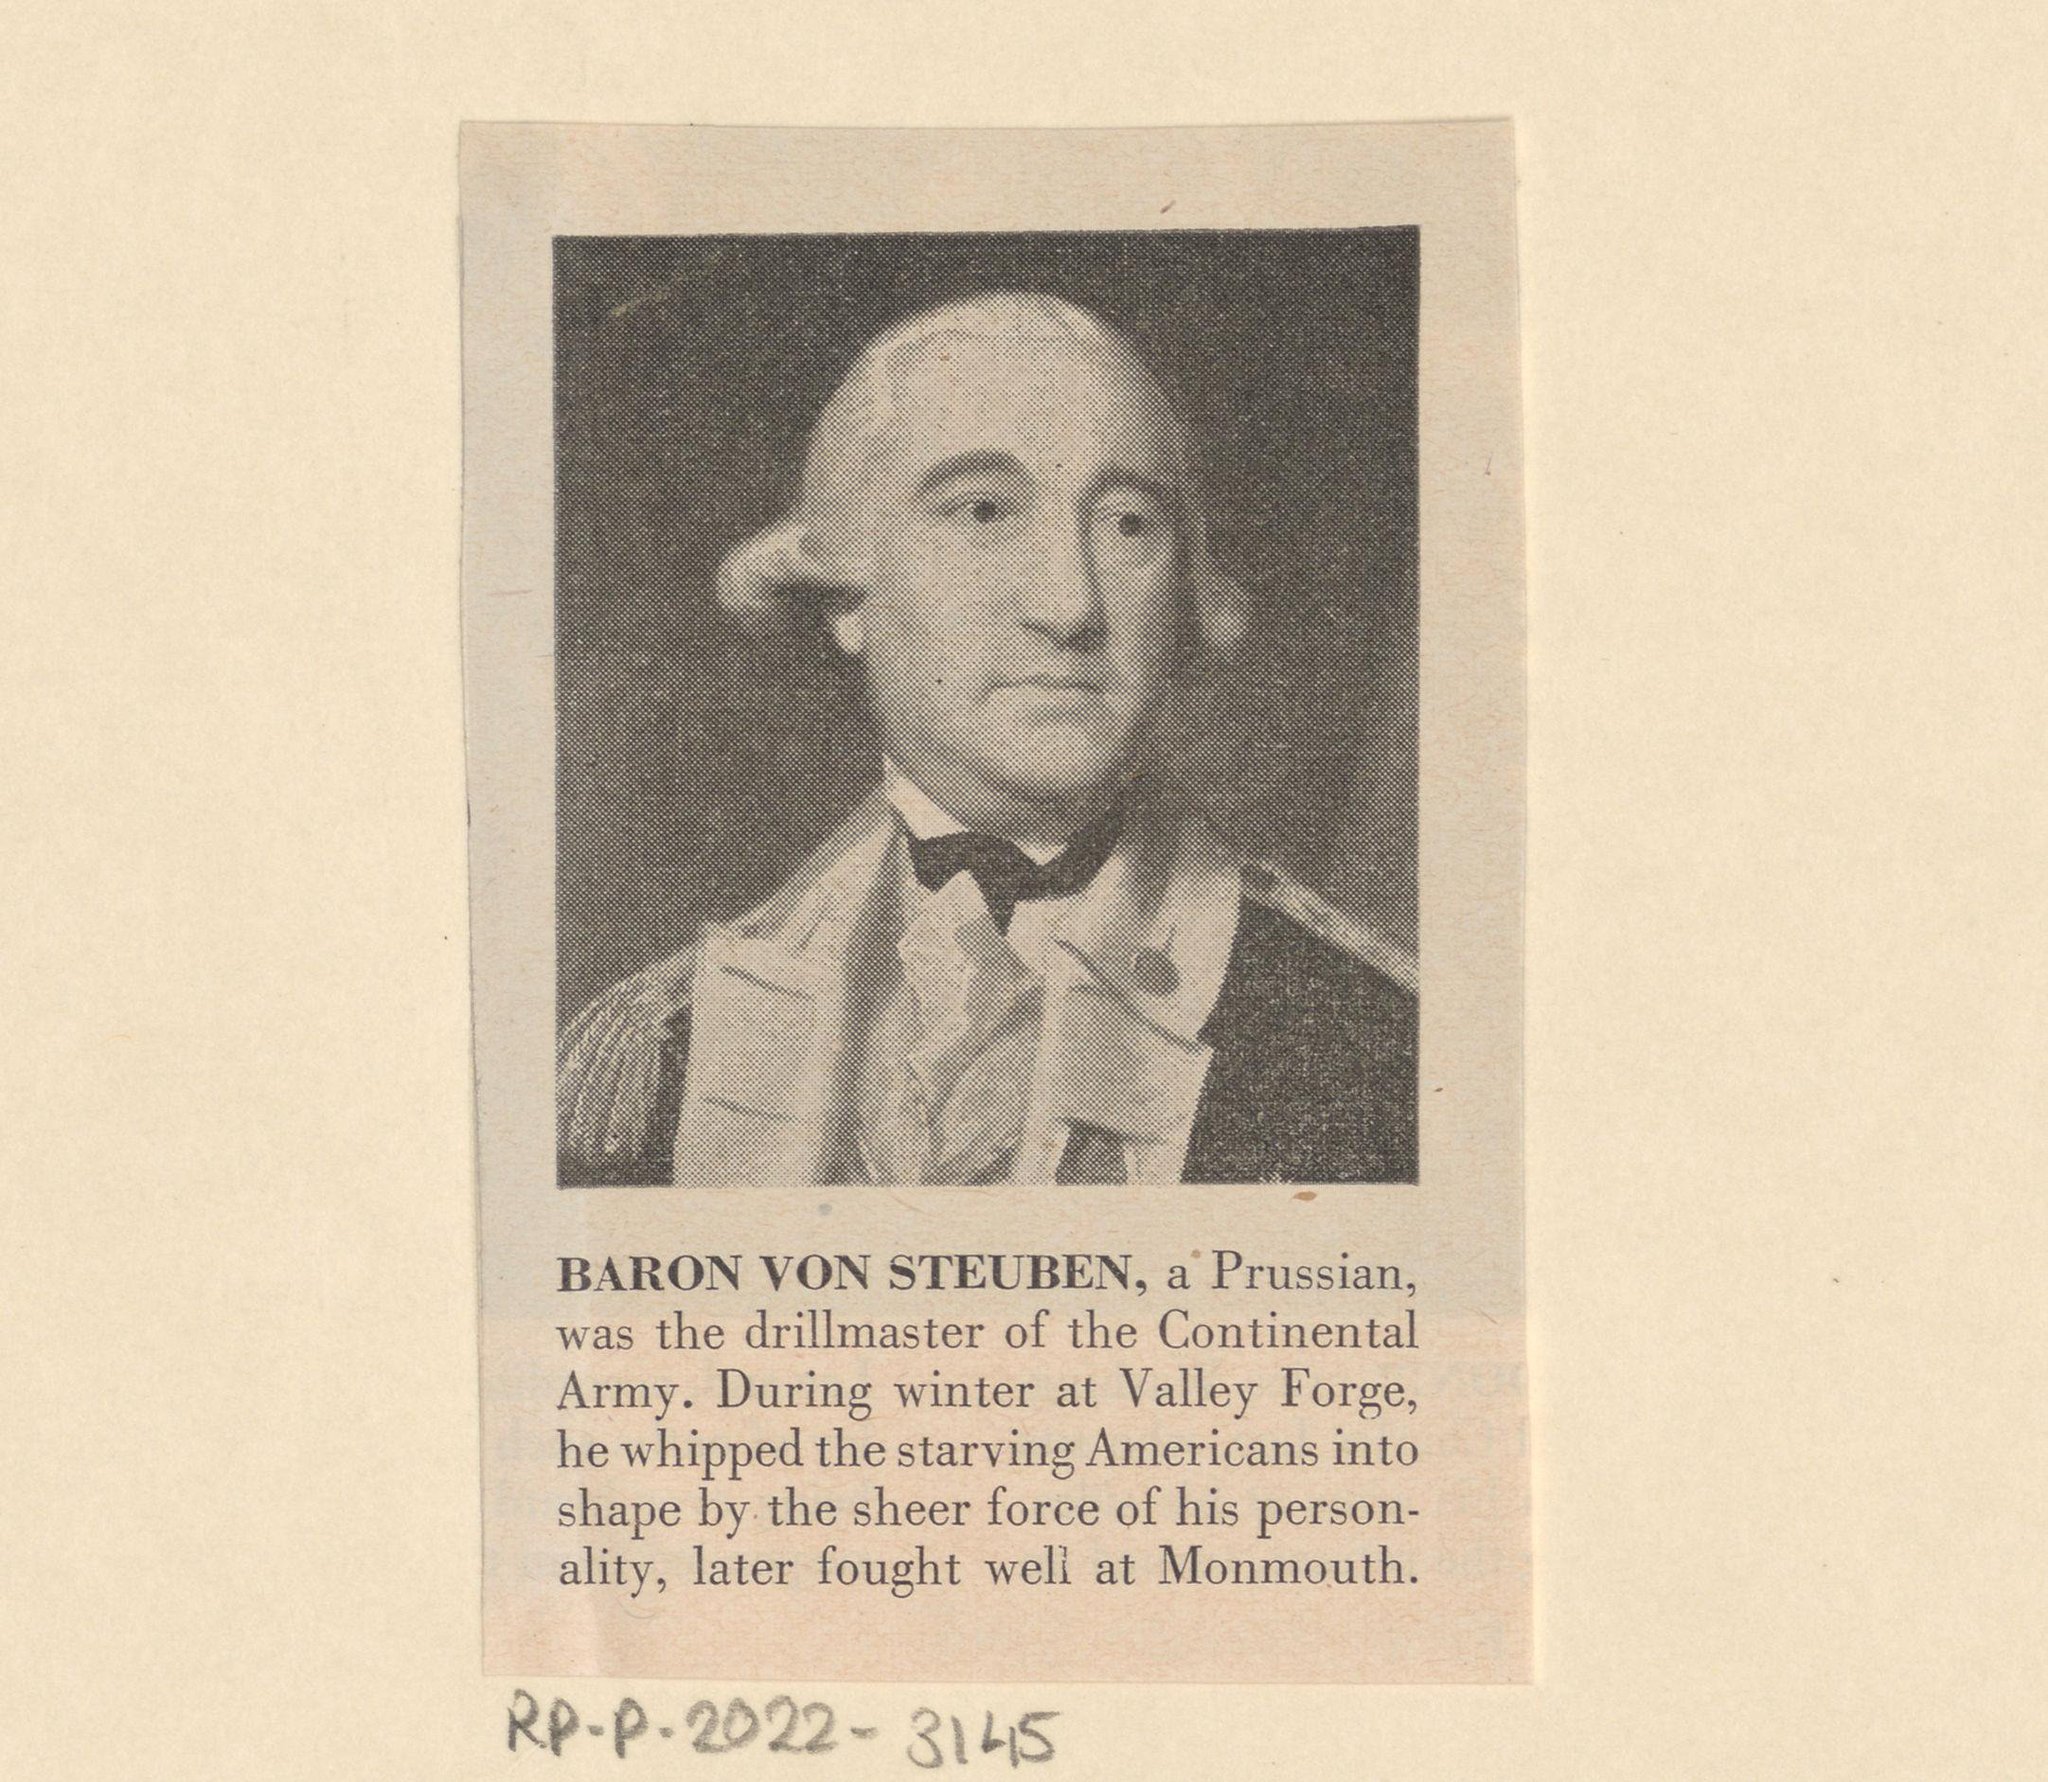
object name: photomechanical print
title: Portret van Friedrich Wilhelm von Steuben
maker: Anonymous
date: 1882-1970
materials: paper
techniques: letterpress printing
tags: other sovereign (baron), historical persons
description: Fotomechanische afdruk uit een onbekende publicatie.